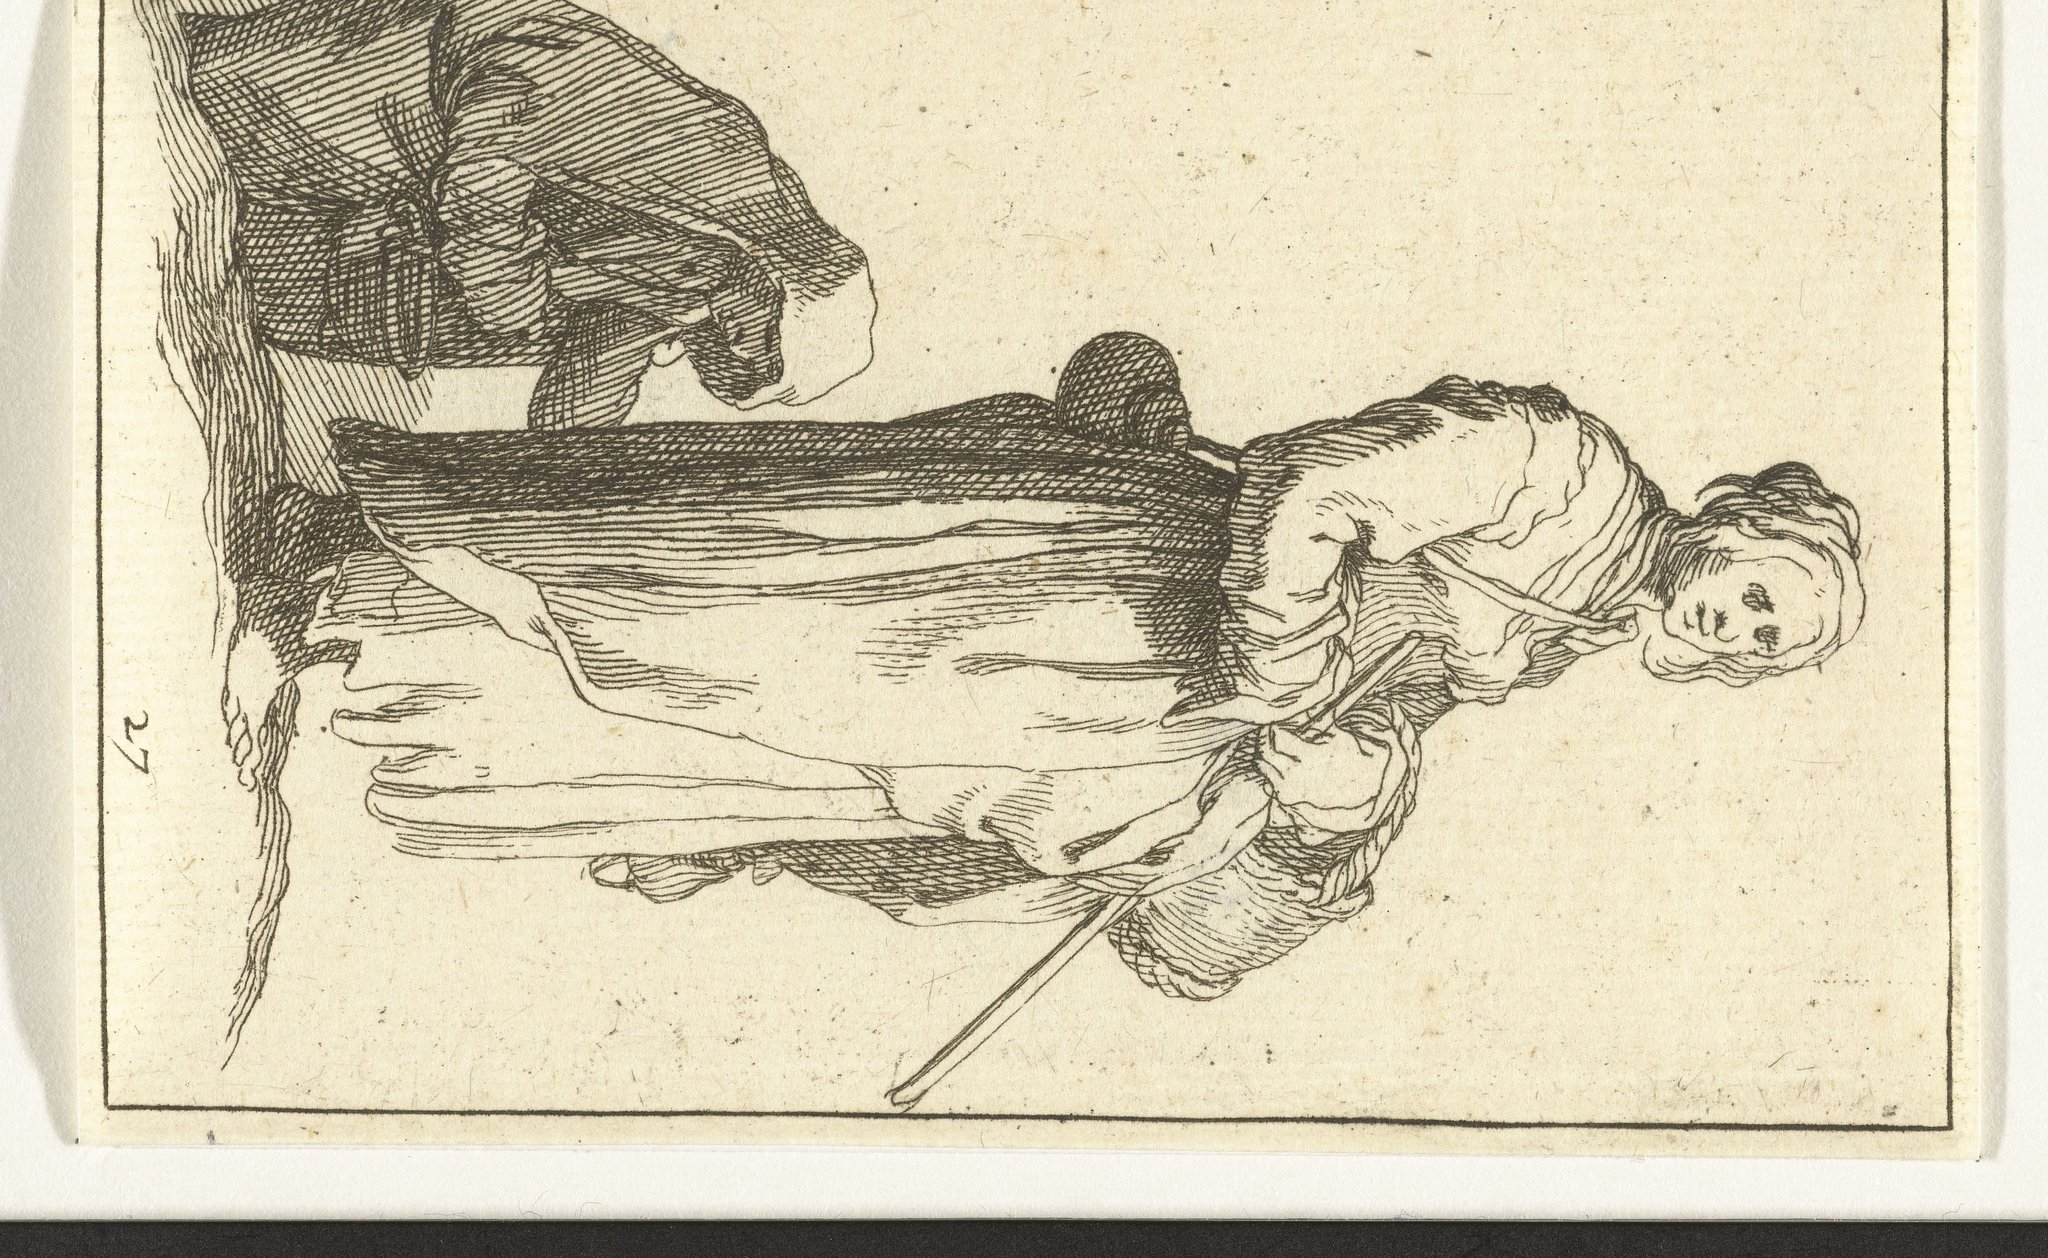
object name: print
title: De kleine figuren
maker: frederick bloemaert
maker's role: print maker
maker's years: 1614-1669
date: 1635-1669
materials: paper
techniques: engraving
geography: utrecht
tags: farmers - aa - female farmer, farmer's wife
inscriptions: collector's mark: Lugt 2233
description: Staande vrouw, zijwaarts afgebeeld, draagt een stok en mand. Achter haar knielt een vrouw met een emmer en verschikt iets aan de rok van de eerste vrouw.